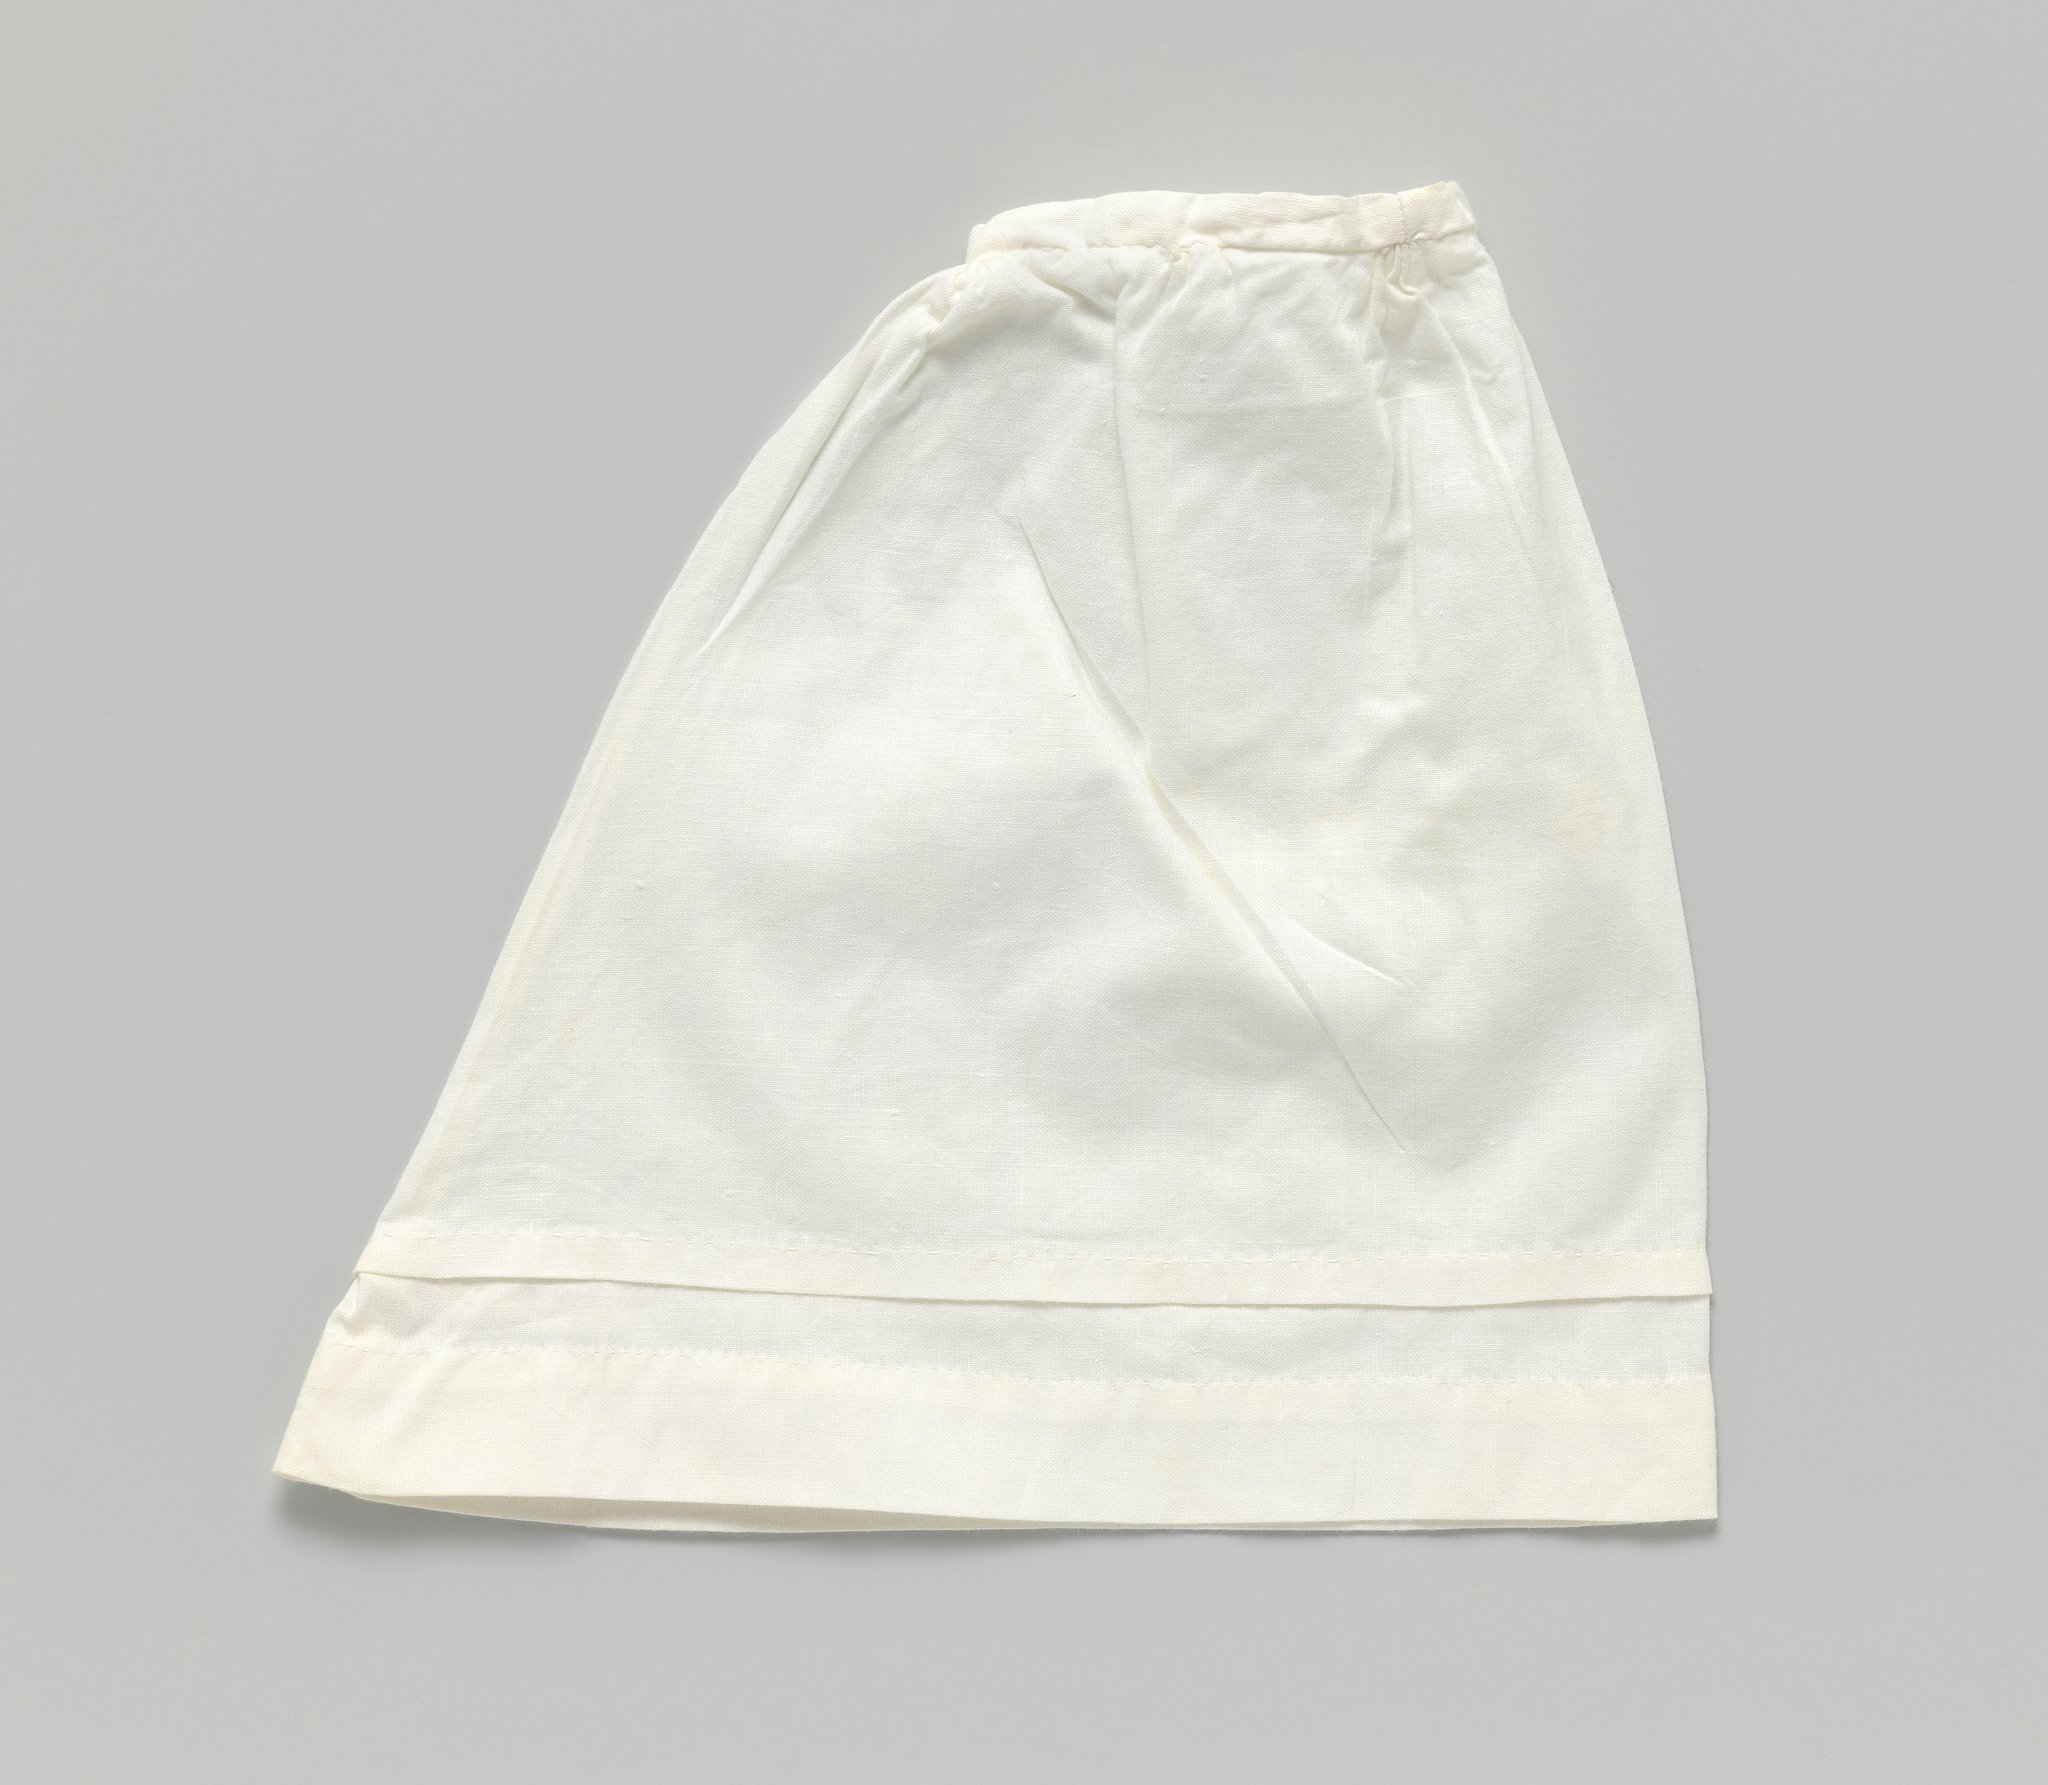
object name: underskirt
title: Onderrok met één oprijg.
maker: Anonymous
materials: cotton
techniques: sewing, weave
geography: netherlands